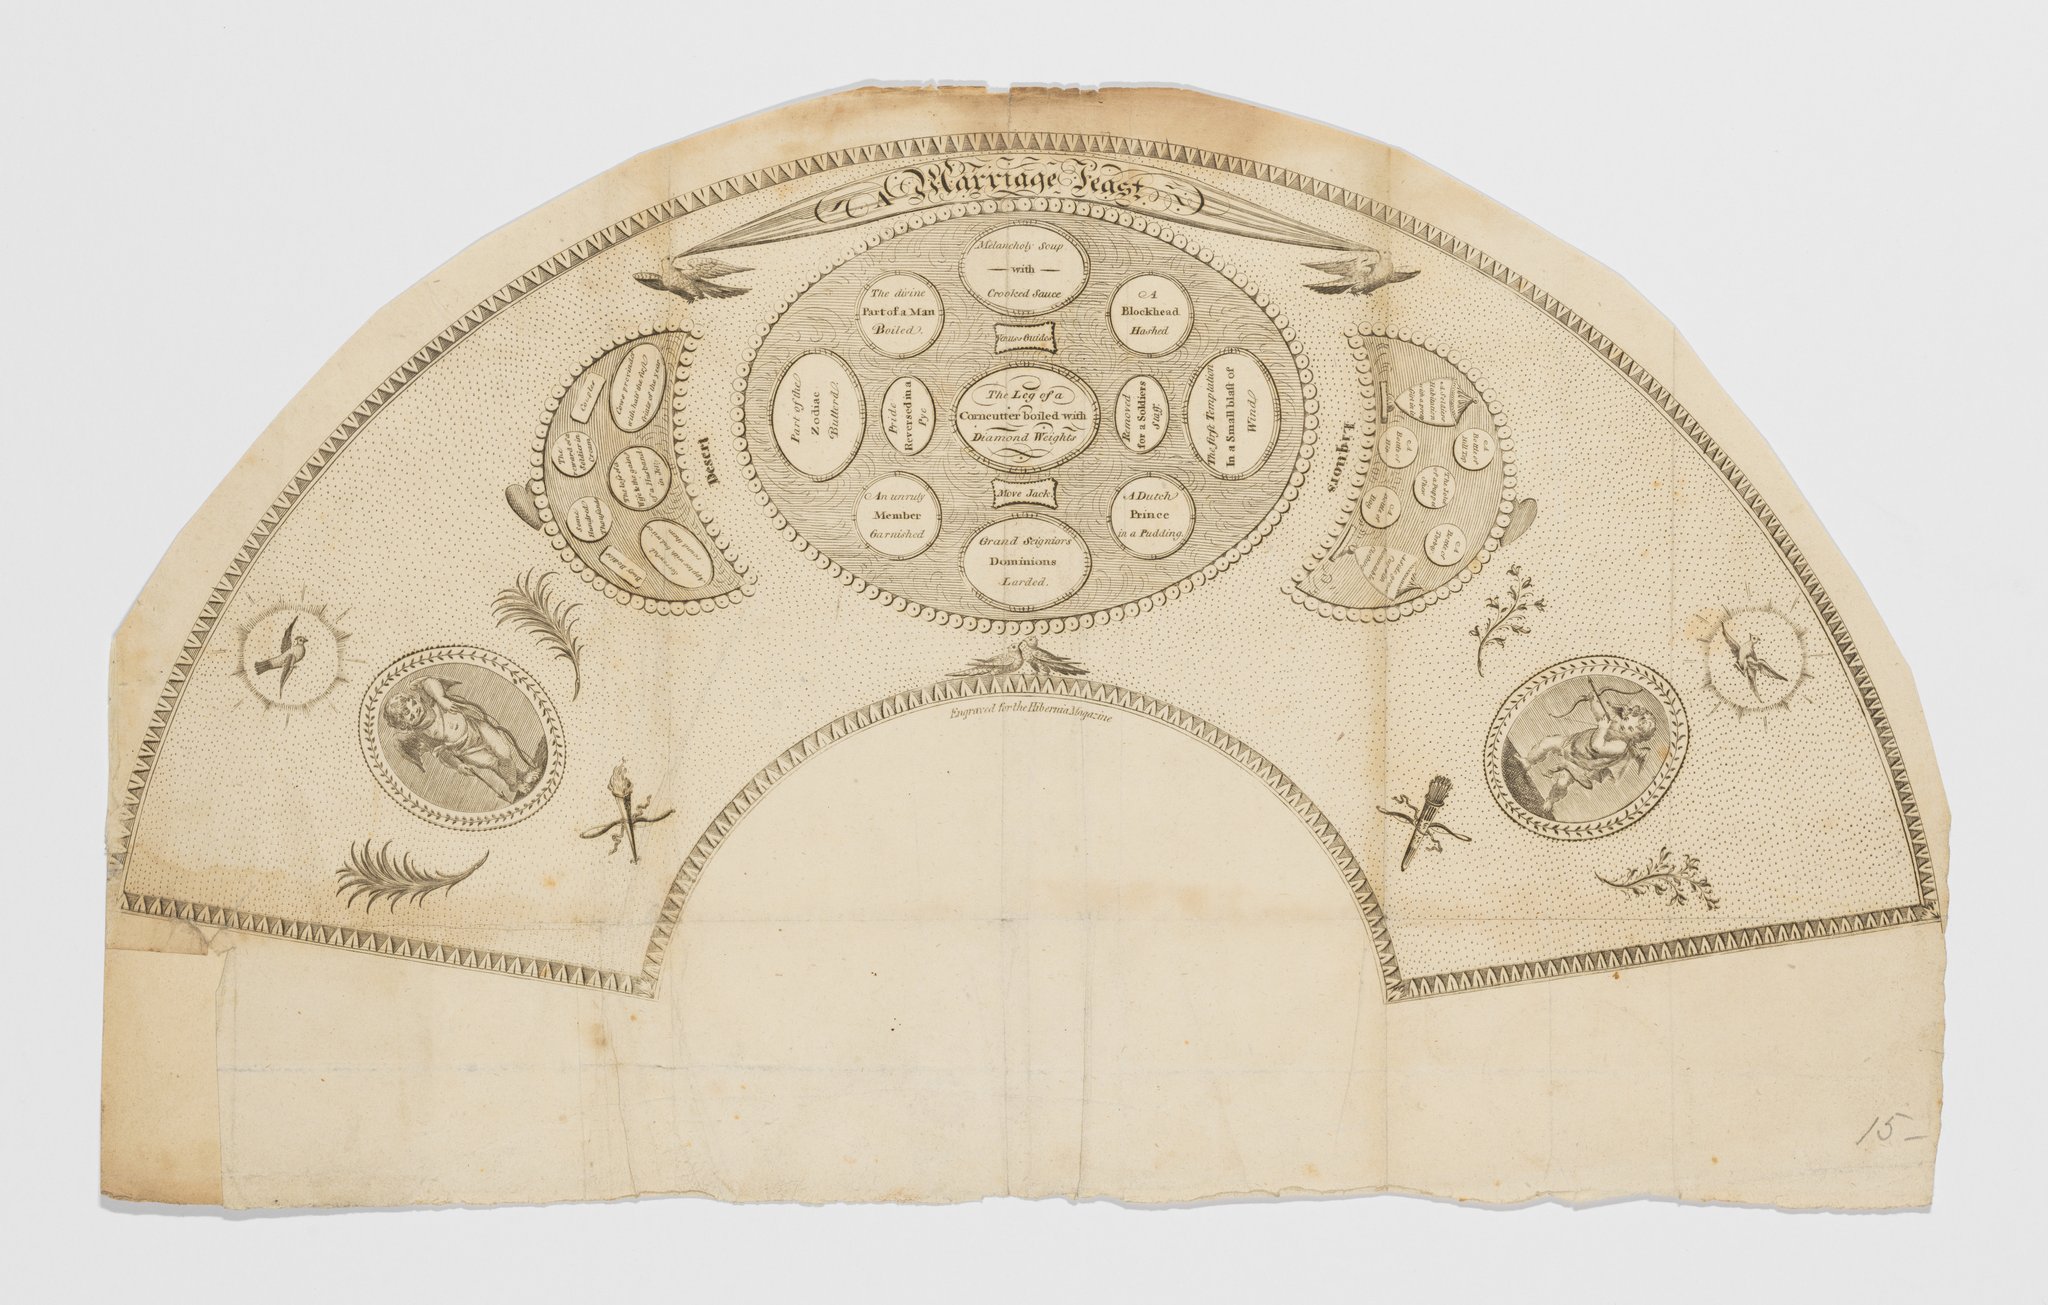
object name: print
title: A Marriage Feast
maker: anonymous, british, 18th–19th century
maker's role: artist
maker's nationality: british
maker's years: 1700-1900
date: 1810-1811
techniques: engraving